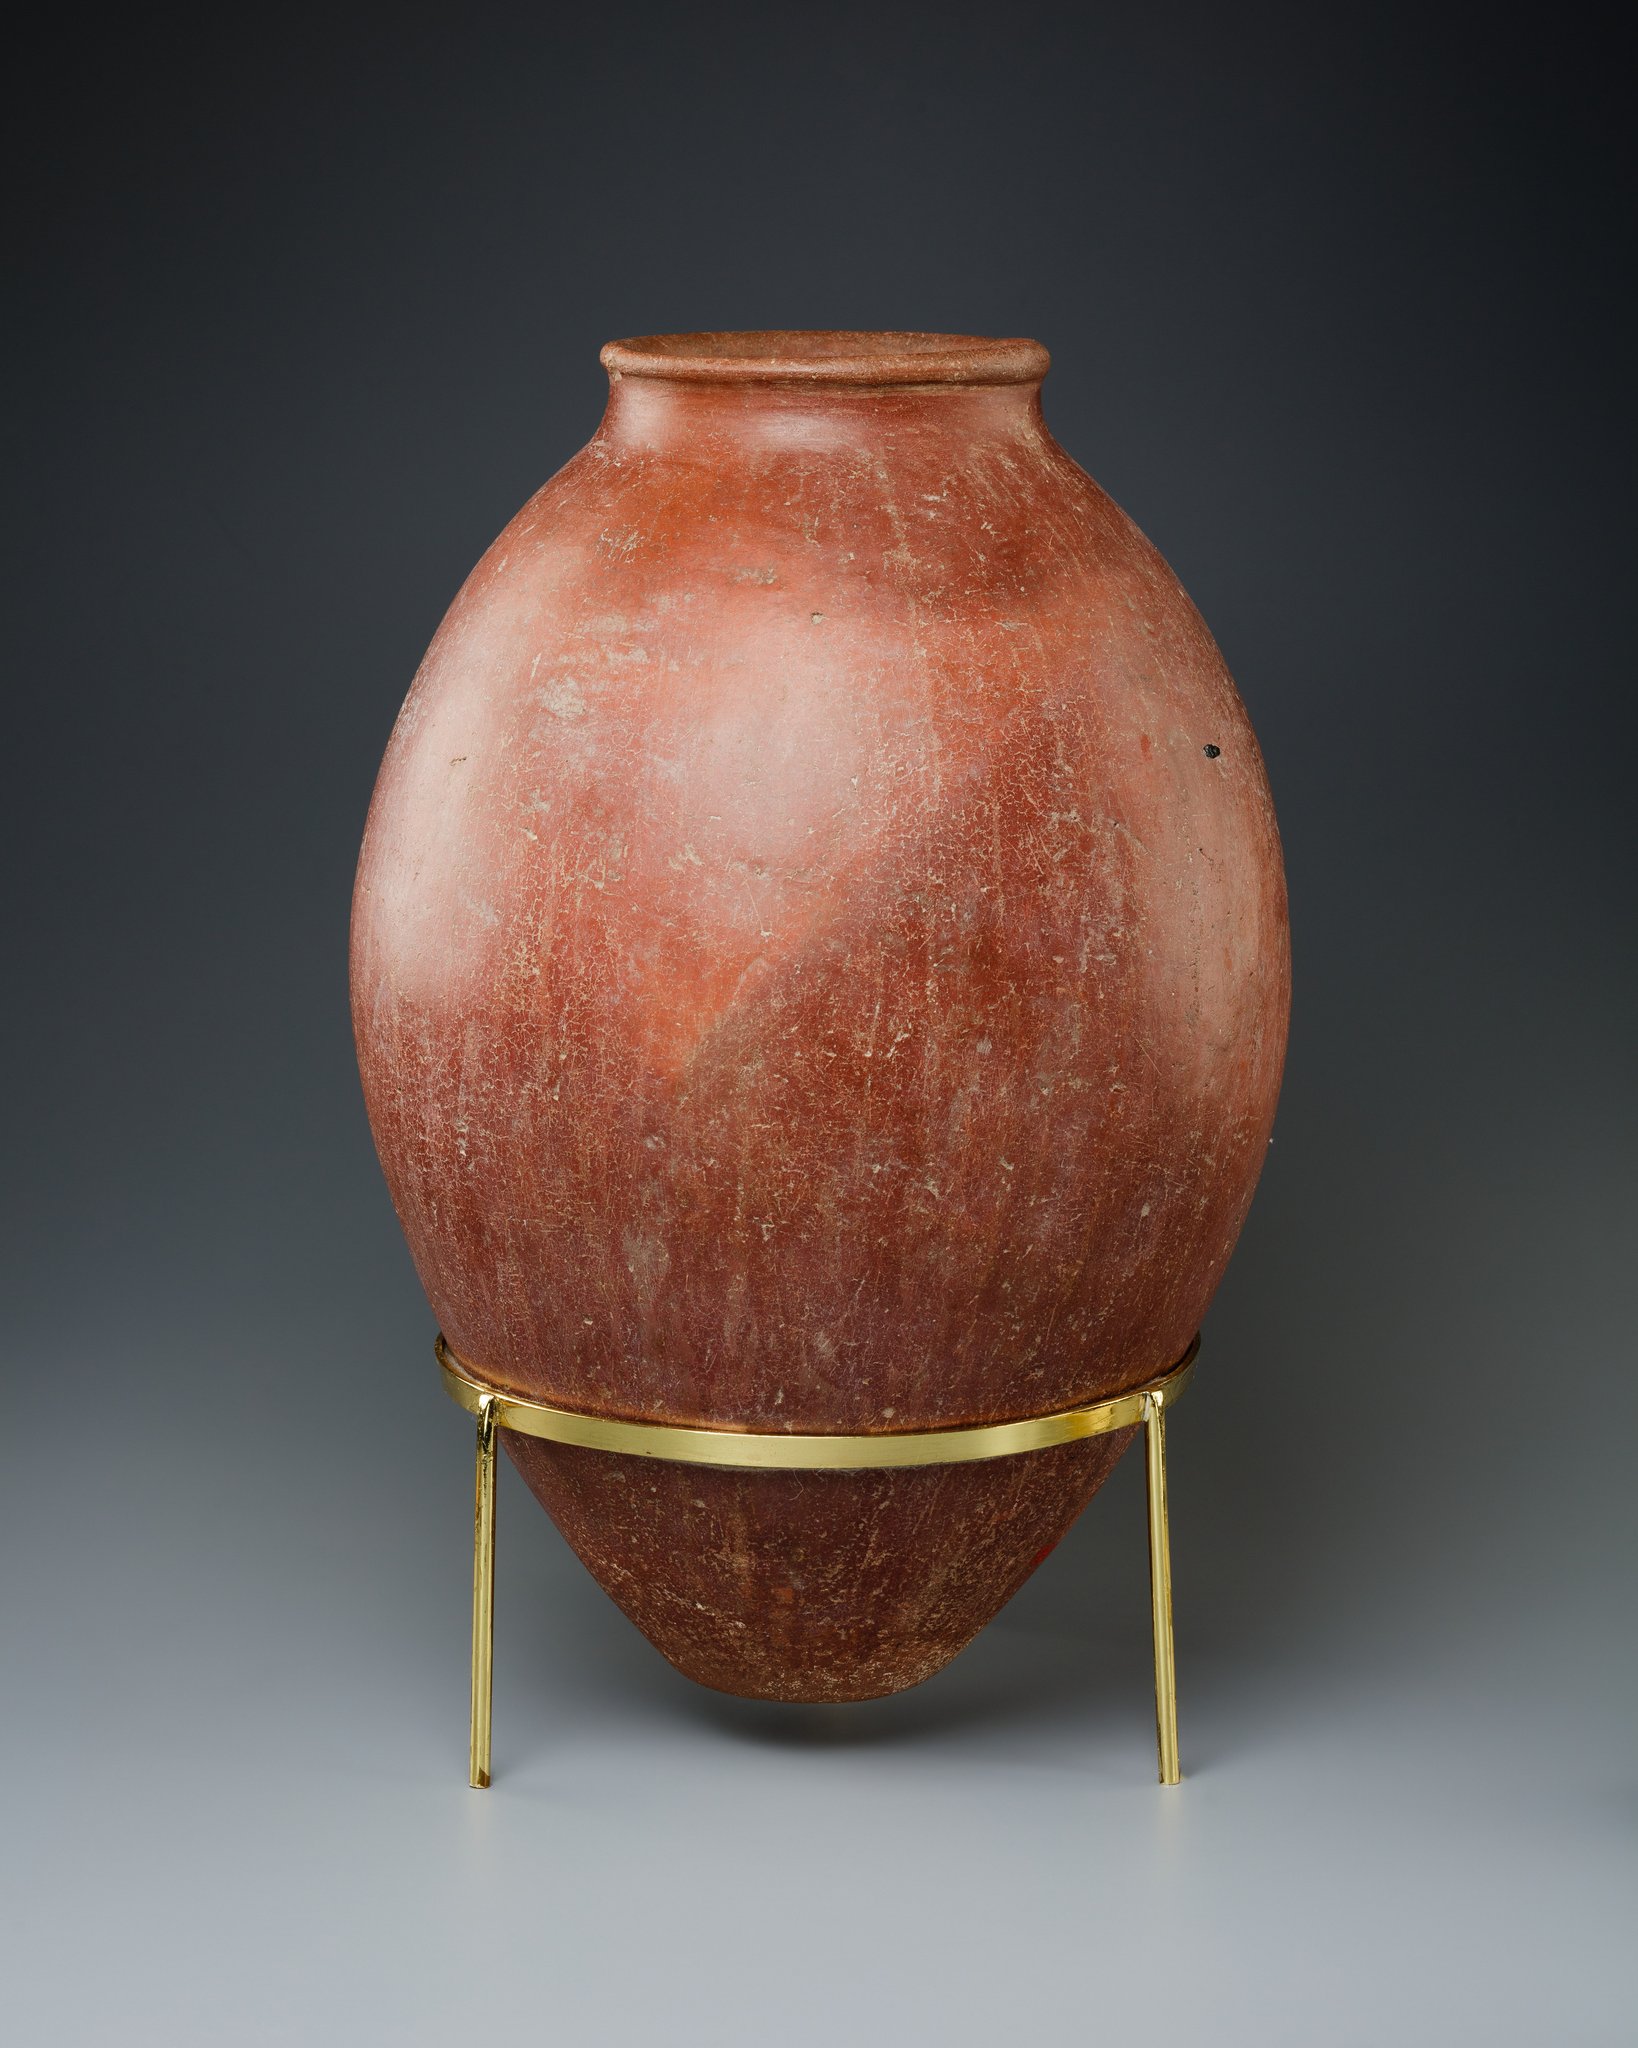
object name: jar, red polished ware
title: Red polished ware jar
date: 3850-2960 BCE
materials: pottery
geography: egypt